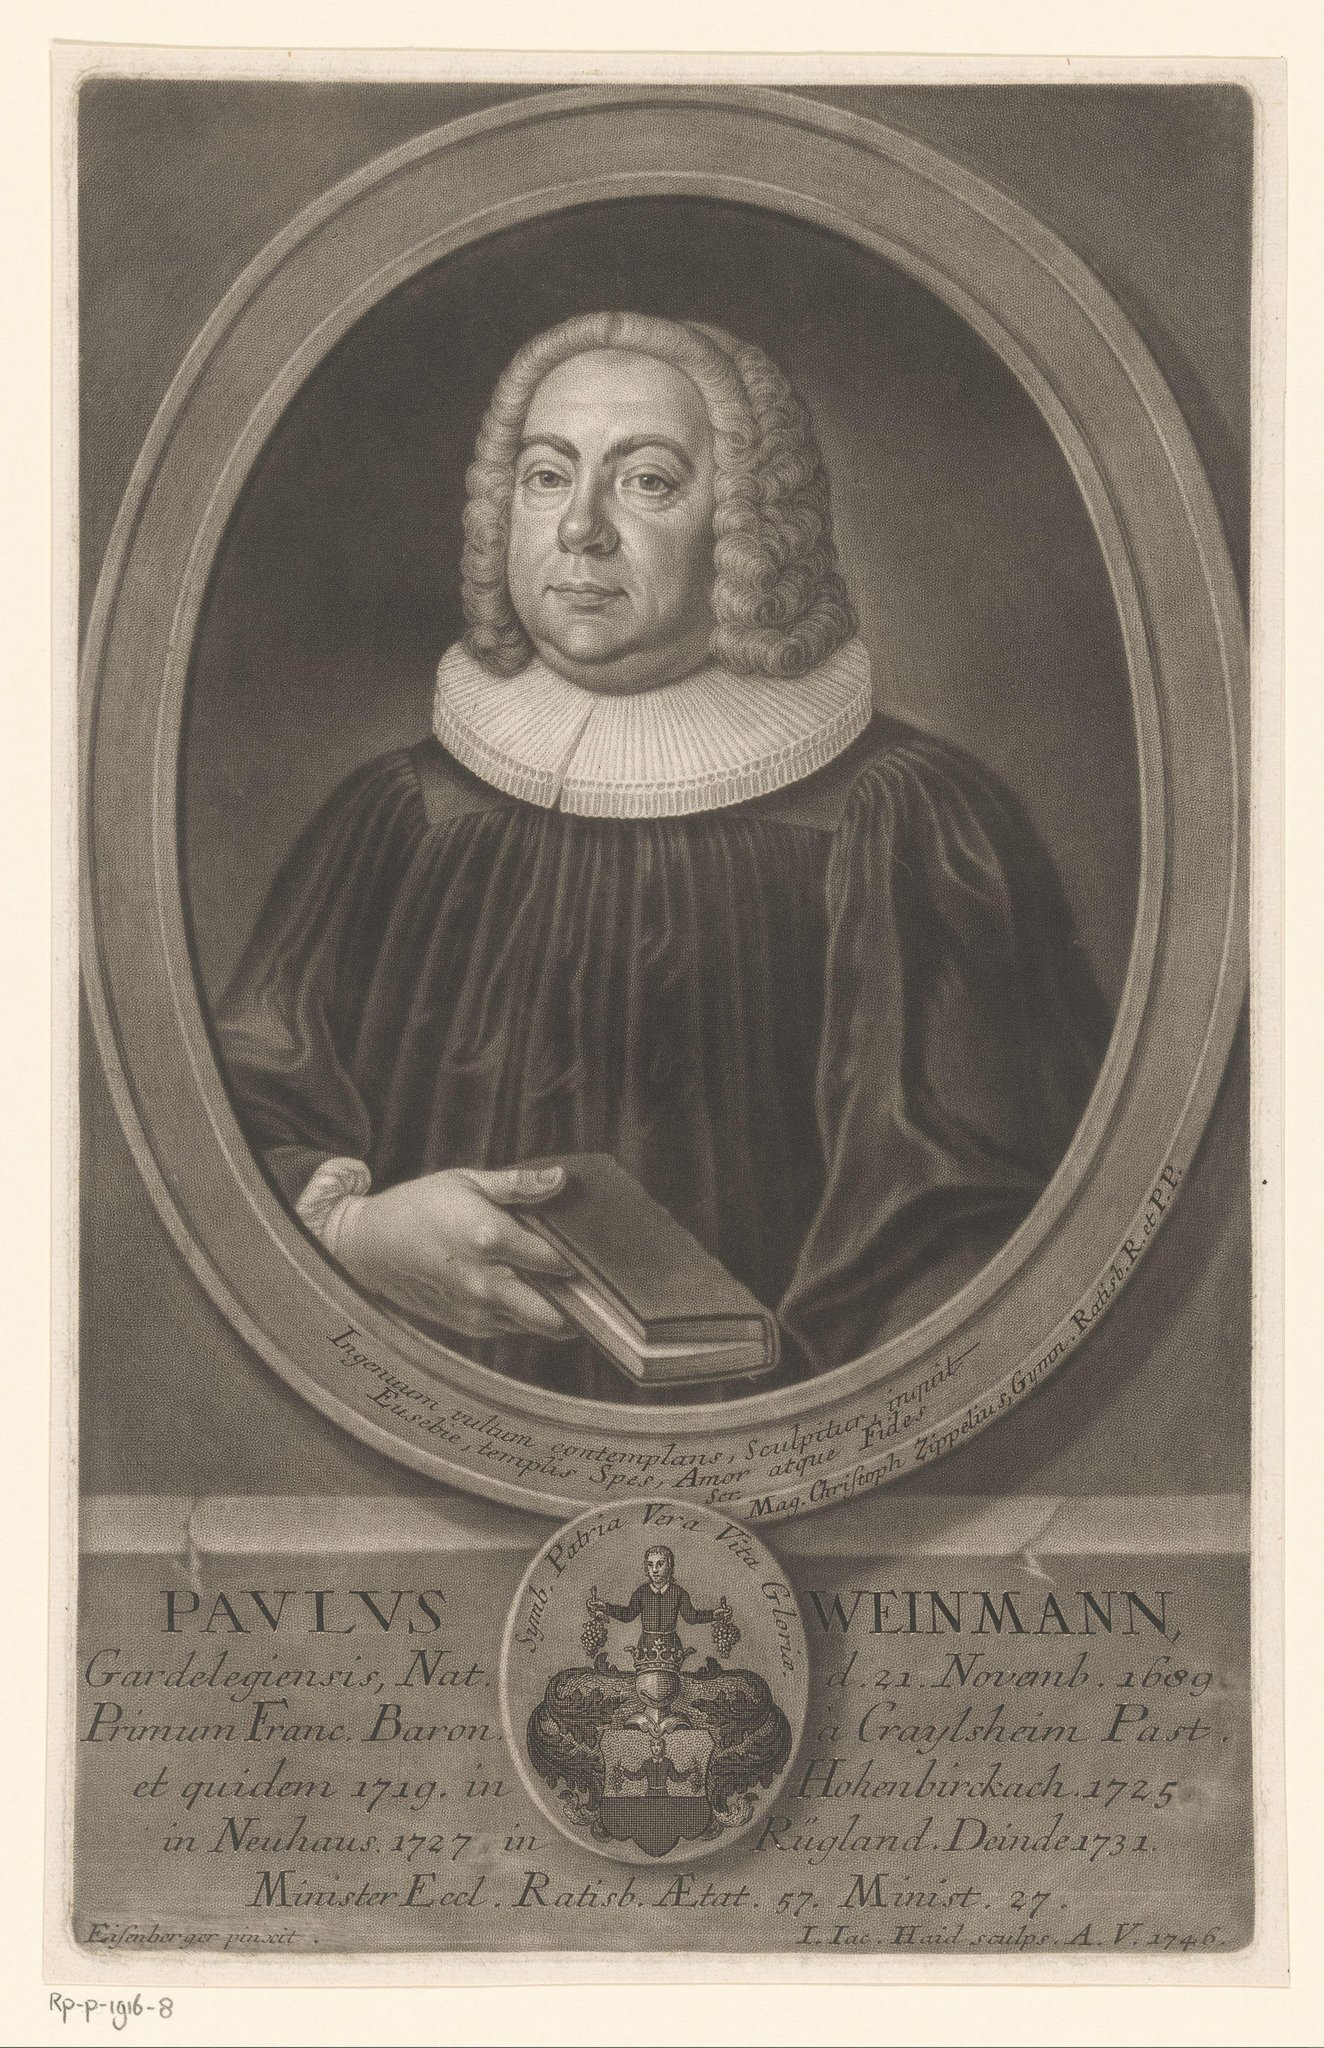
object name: print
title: Portret van Johann Paulus Weinmann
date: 1746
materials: paper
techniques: etching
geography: augsburg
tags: historical persons, book, armorial bearing, heraldry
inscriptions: collector's mark: Lugt 2228